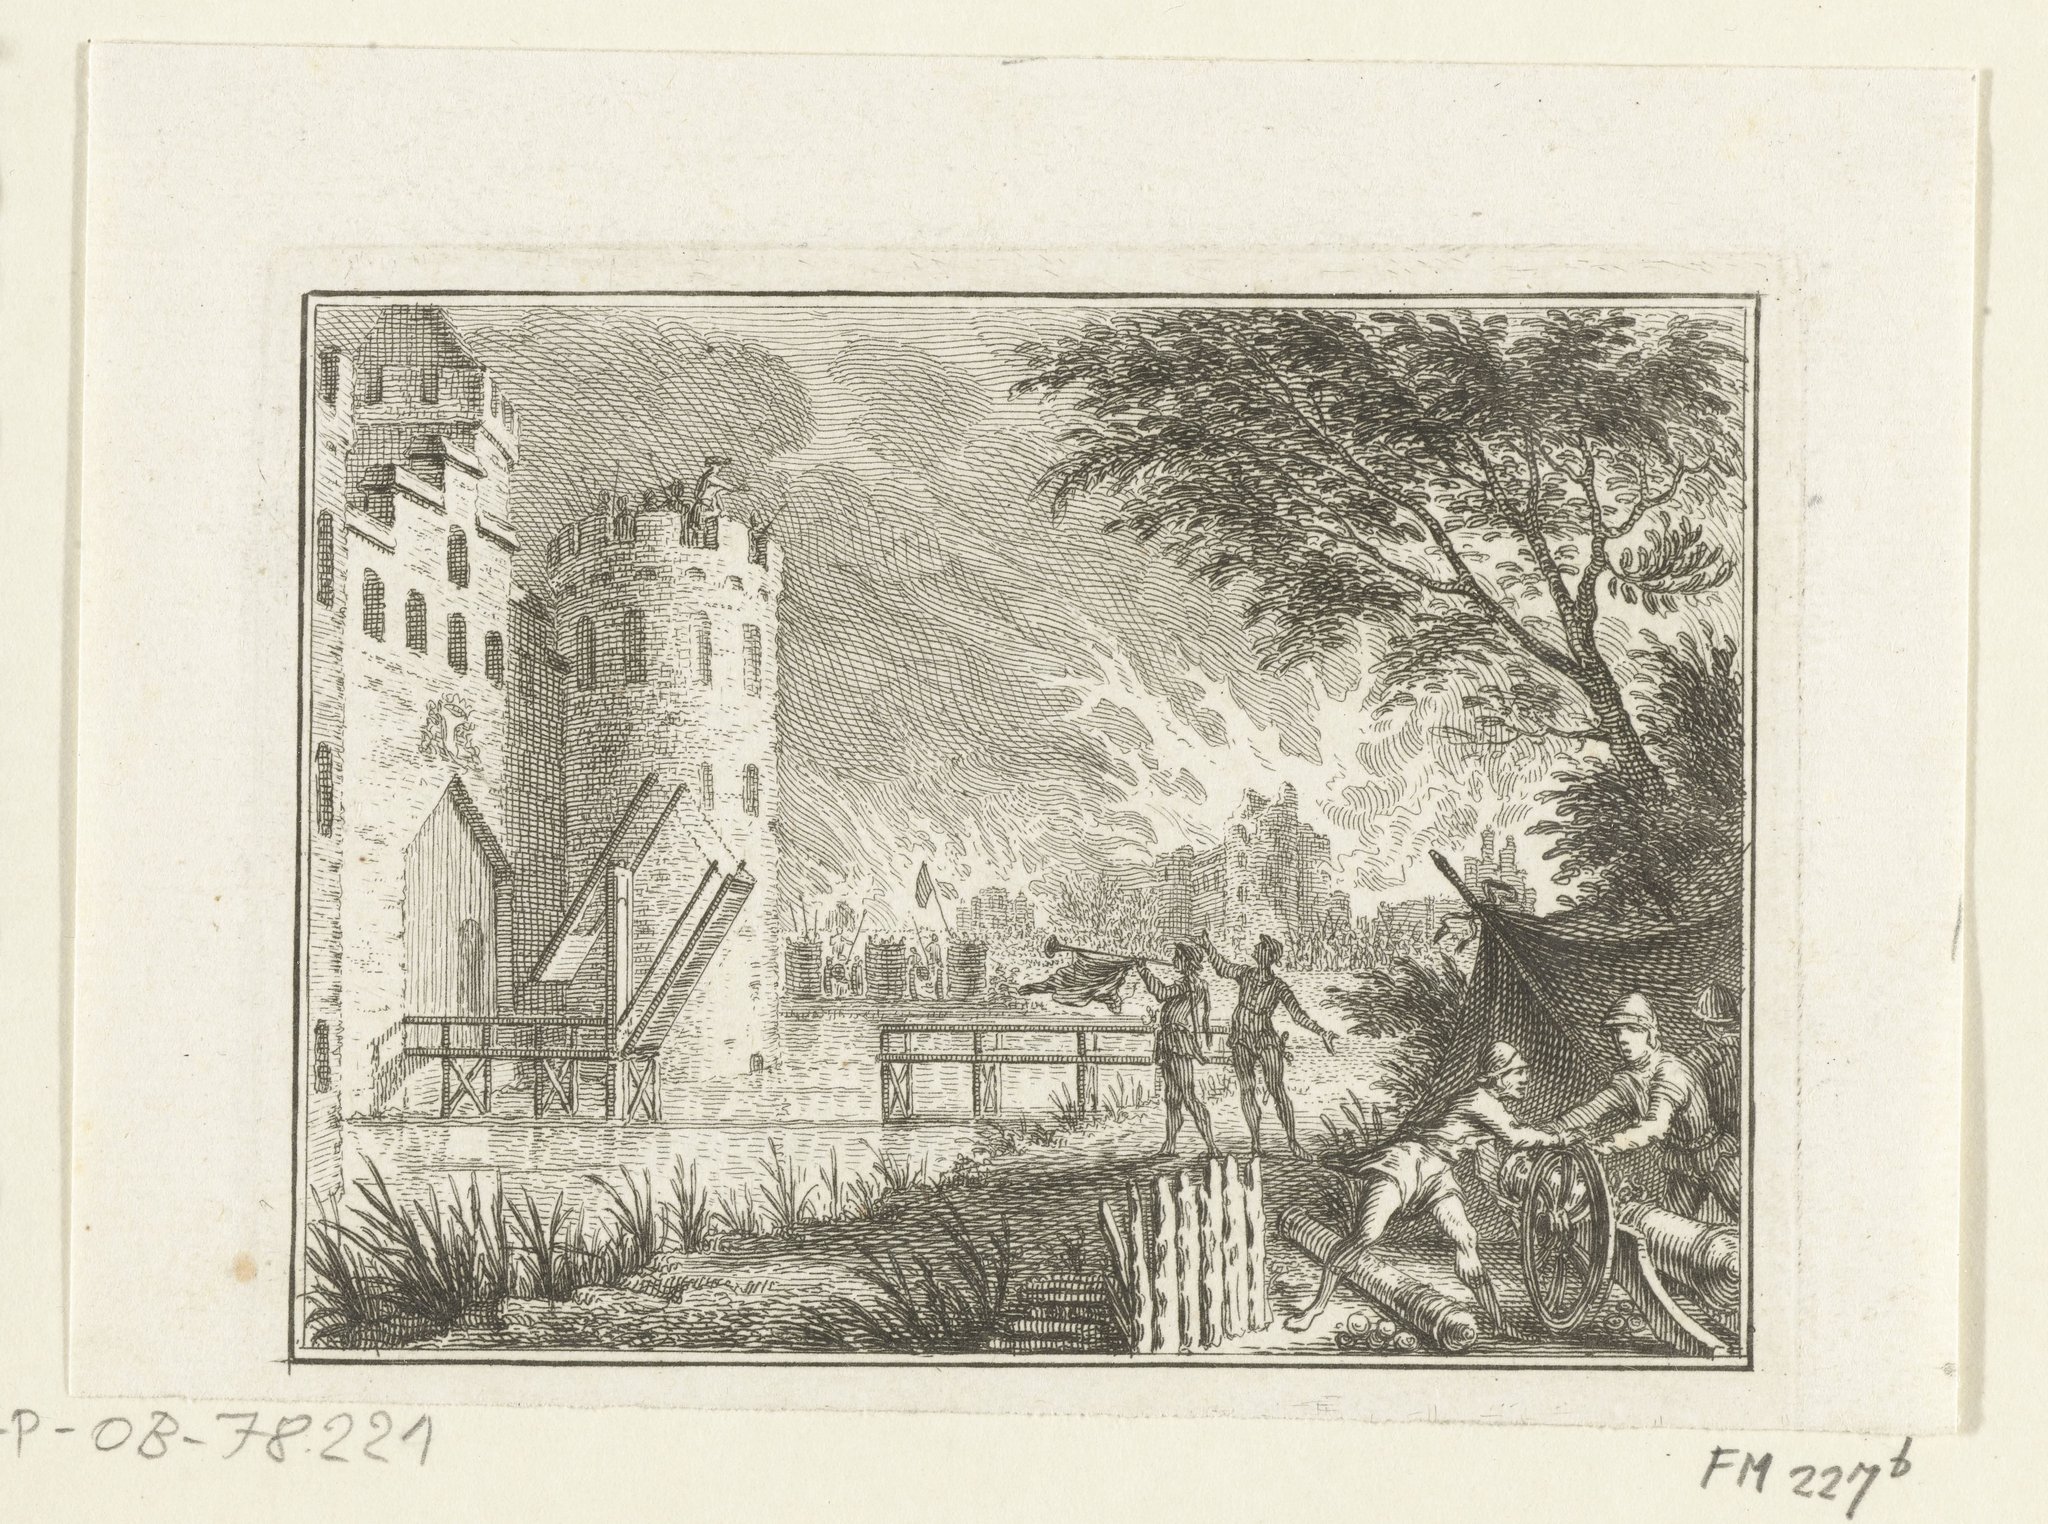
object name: history print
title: Het vernielen van de Hoekse kastelen, 1350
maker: simon fokke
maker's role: draughtsman, print maker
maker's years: 1712-1784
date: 1722-1750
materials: paper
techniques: etching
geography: northern netherlands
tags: siege, position war, netherlands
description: Illustratie voor: J.W. te Water, De vaderlandsche Historie van den heere J. Wagenaar, verkort, en met leerzaame aanmerkingen, ten dienste der Nederlandsche jeugd, 1784-1800, 4 delen., pl. XXI, blz. 7. Staat vóór de letter.